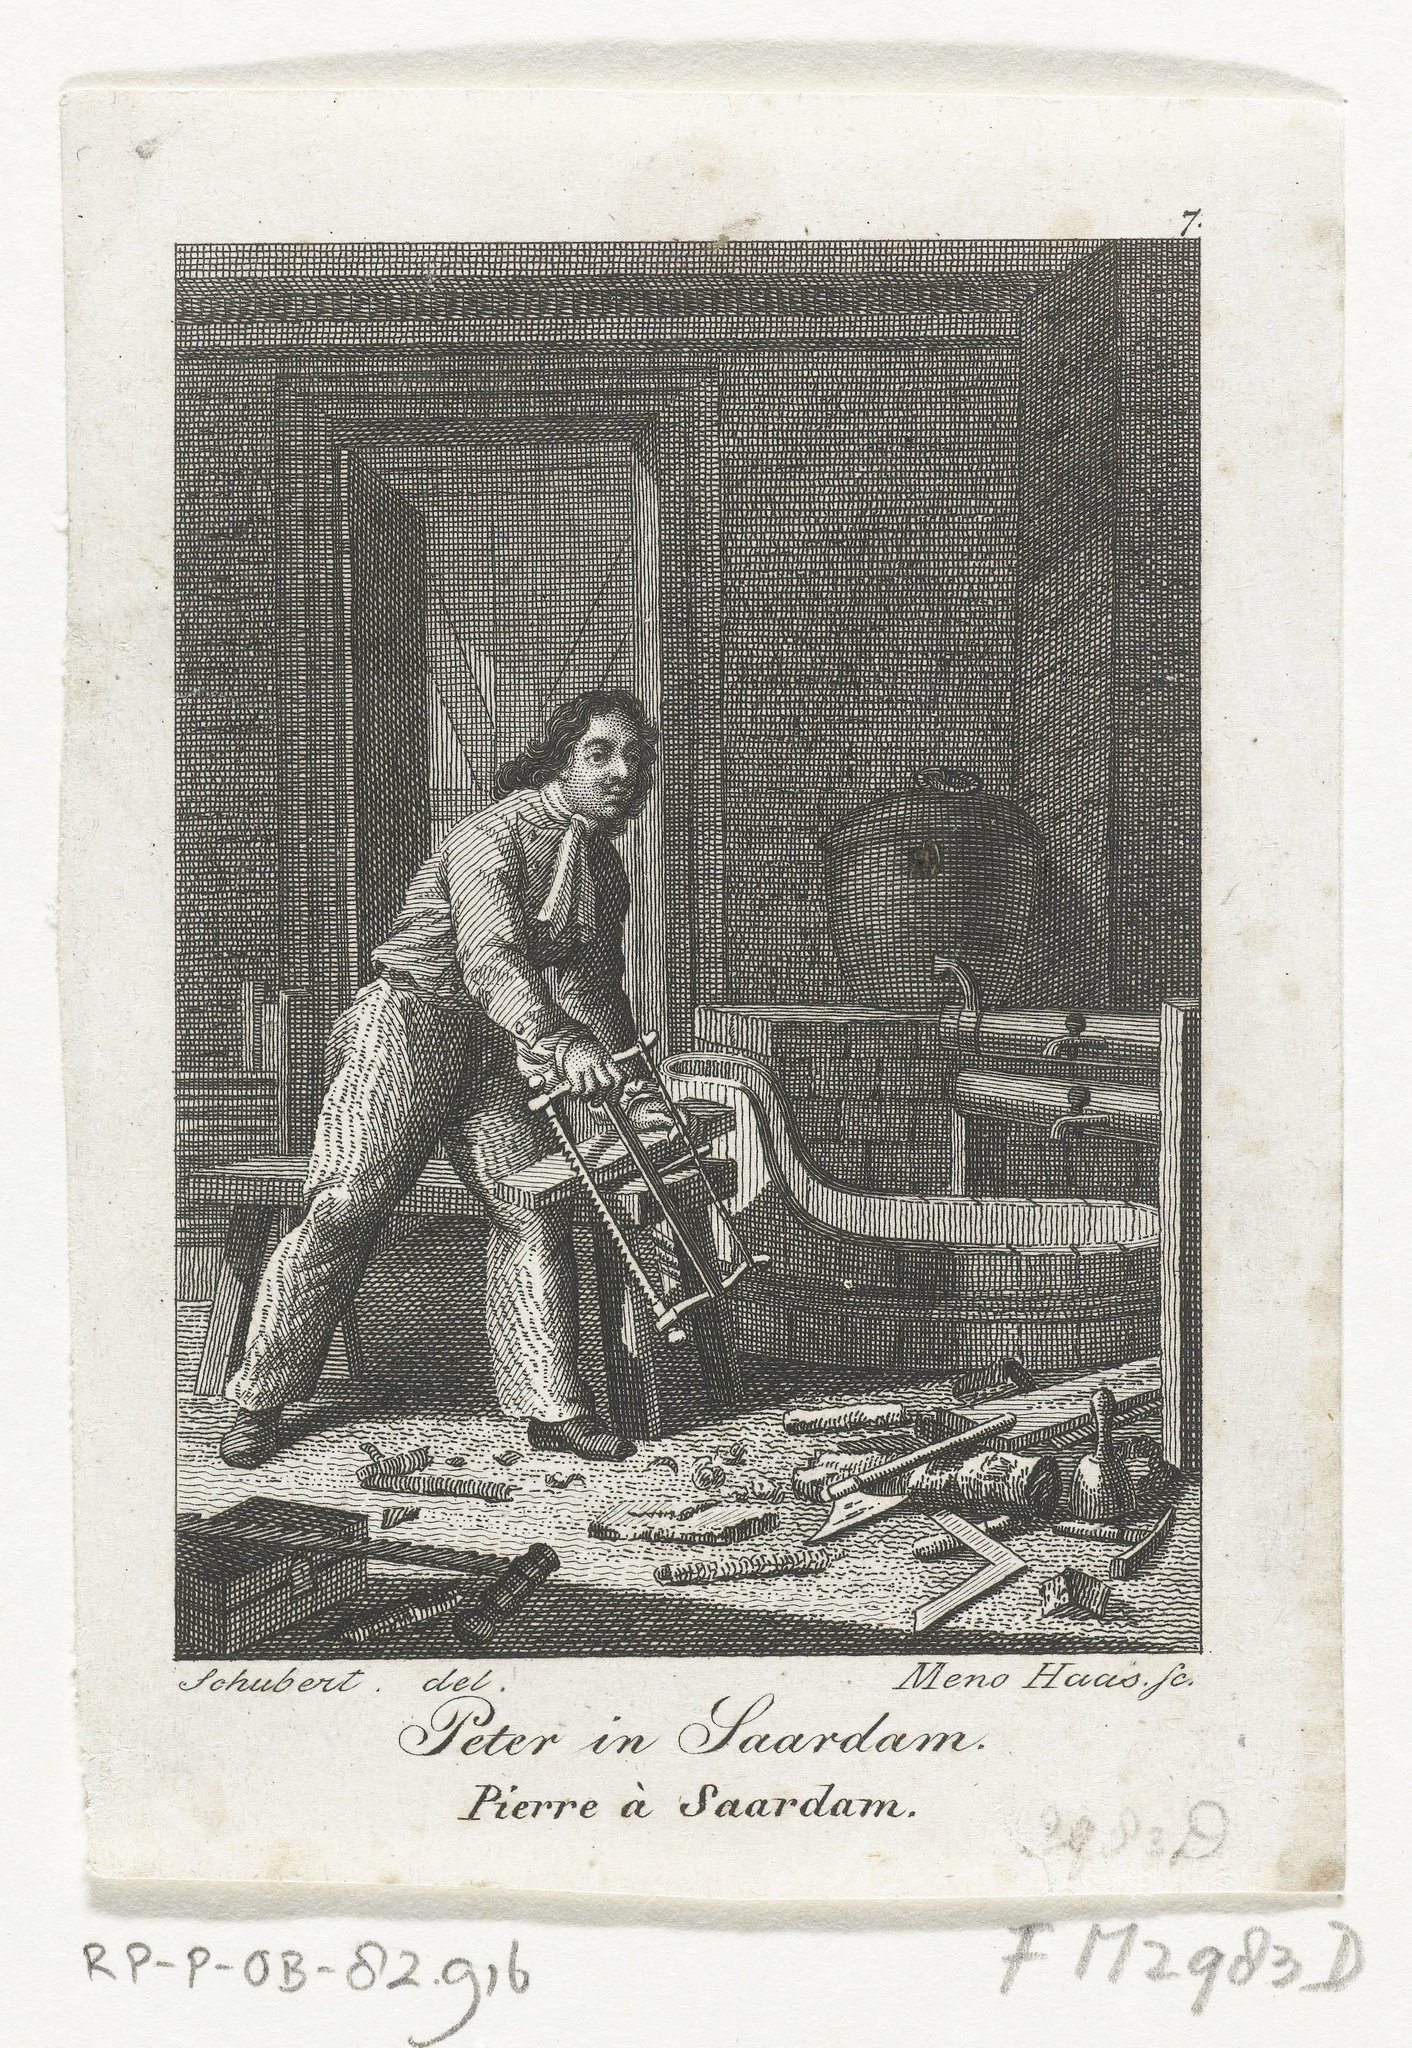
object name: history print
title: Tsaar Peter de Grote in Zaandam, 1697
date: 1762-1833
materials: paper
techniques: etching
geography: netherlands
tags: peter i de grote (tsaar van rusland), shipbuilding industry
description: Illustratie uit een almanak. Dit nummer is een door het RPK toegevoegd nummer en staat niet in Frederik Muller, het werk waar de prent voor is gemaakt of uit afkomstig is, staat wel vermeld in Frederik Muller.